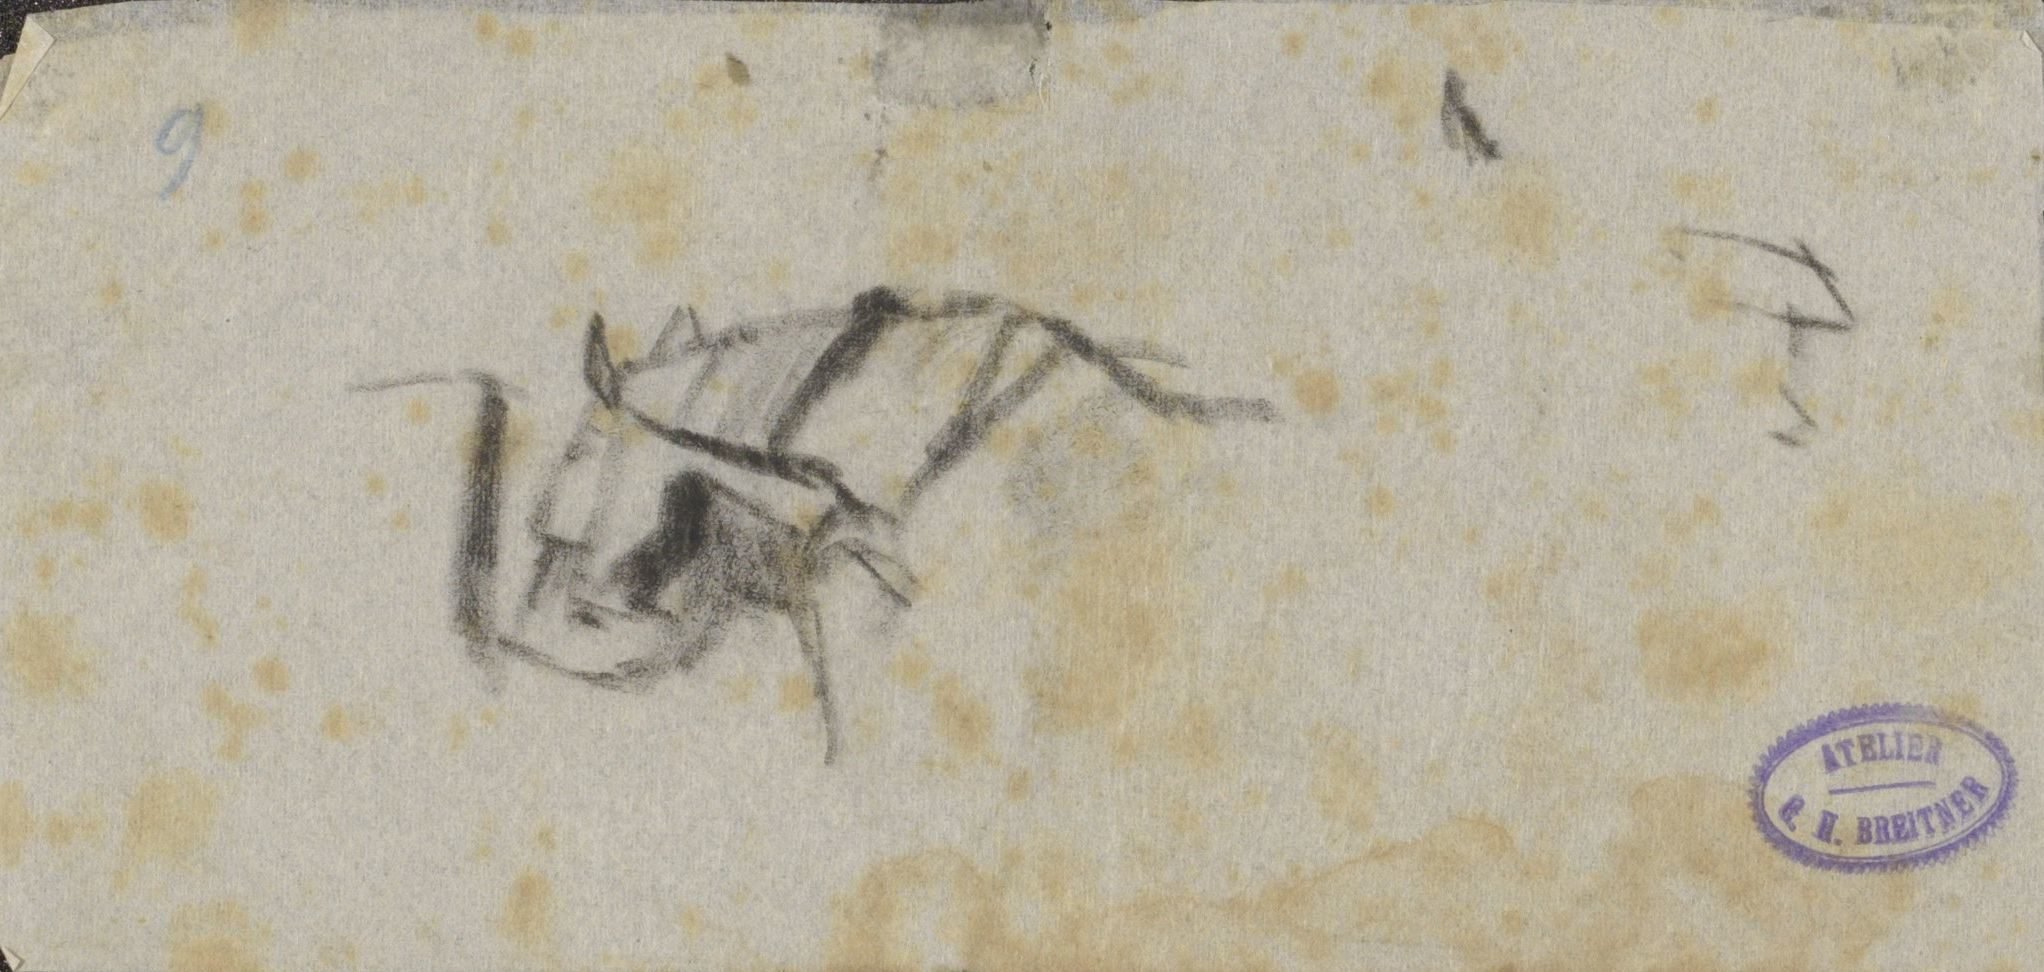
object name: drawing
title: Paard bij een trog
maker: george hendrik breitner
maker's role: draughtsman, painter, print maker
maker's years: 1857-1923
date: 1897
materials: chalk, paper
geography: amsterdam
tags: trough, horse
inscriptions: collector's mark: Lugt 2228, workshop stamp: Lugt 291d